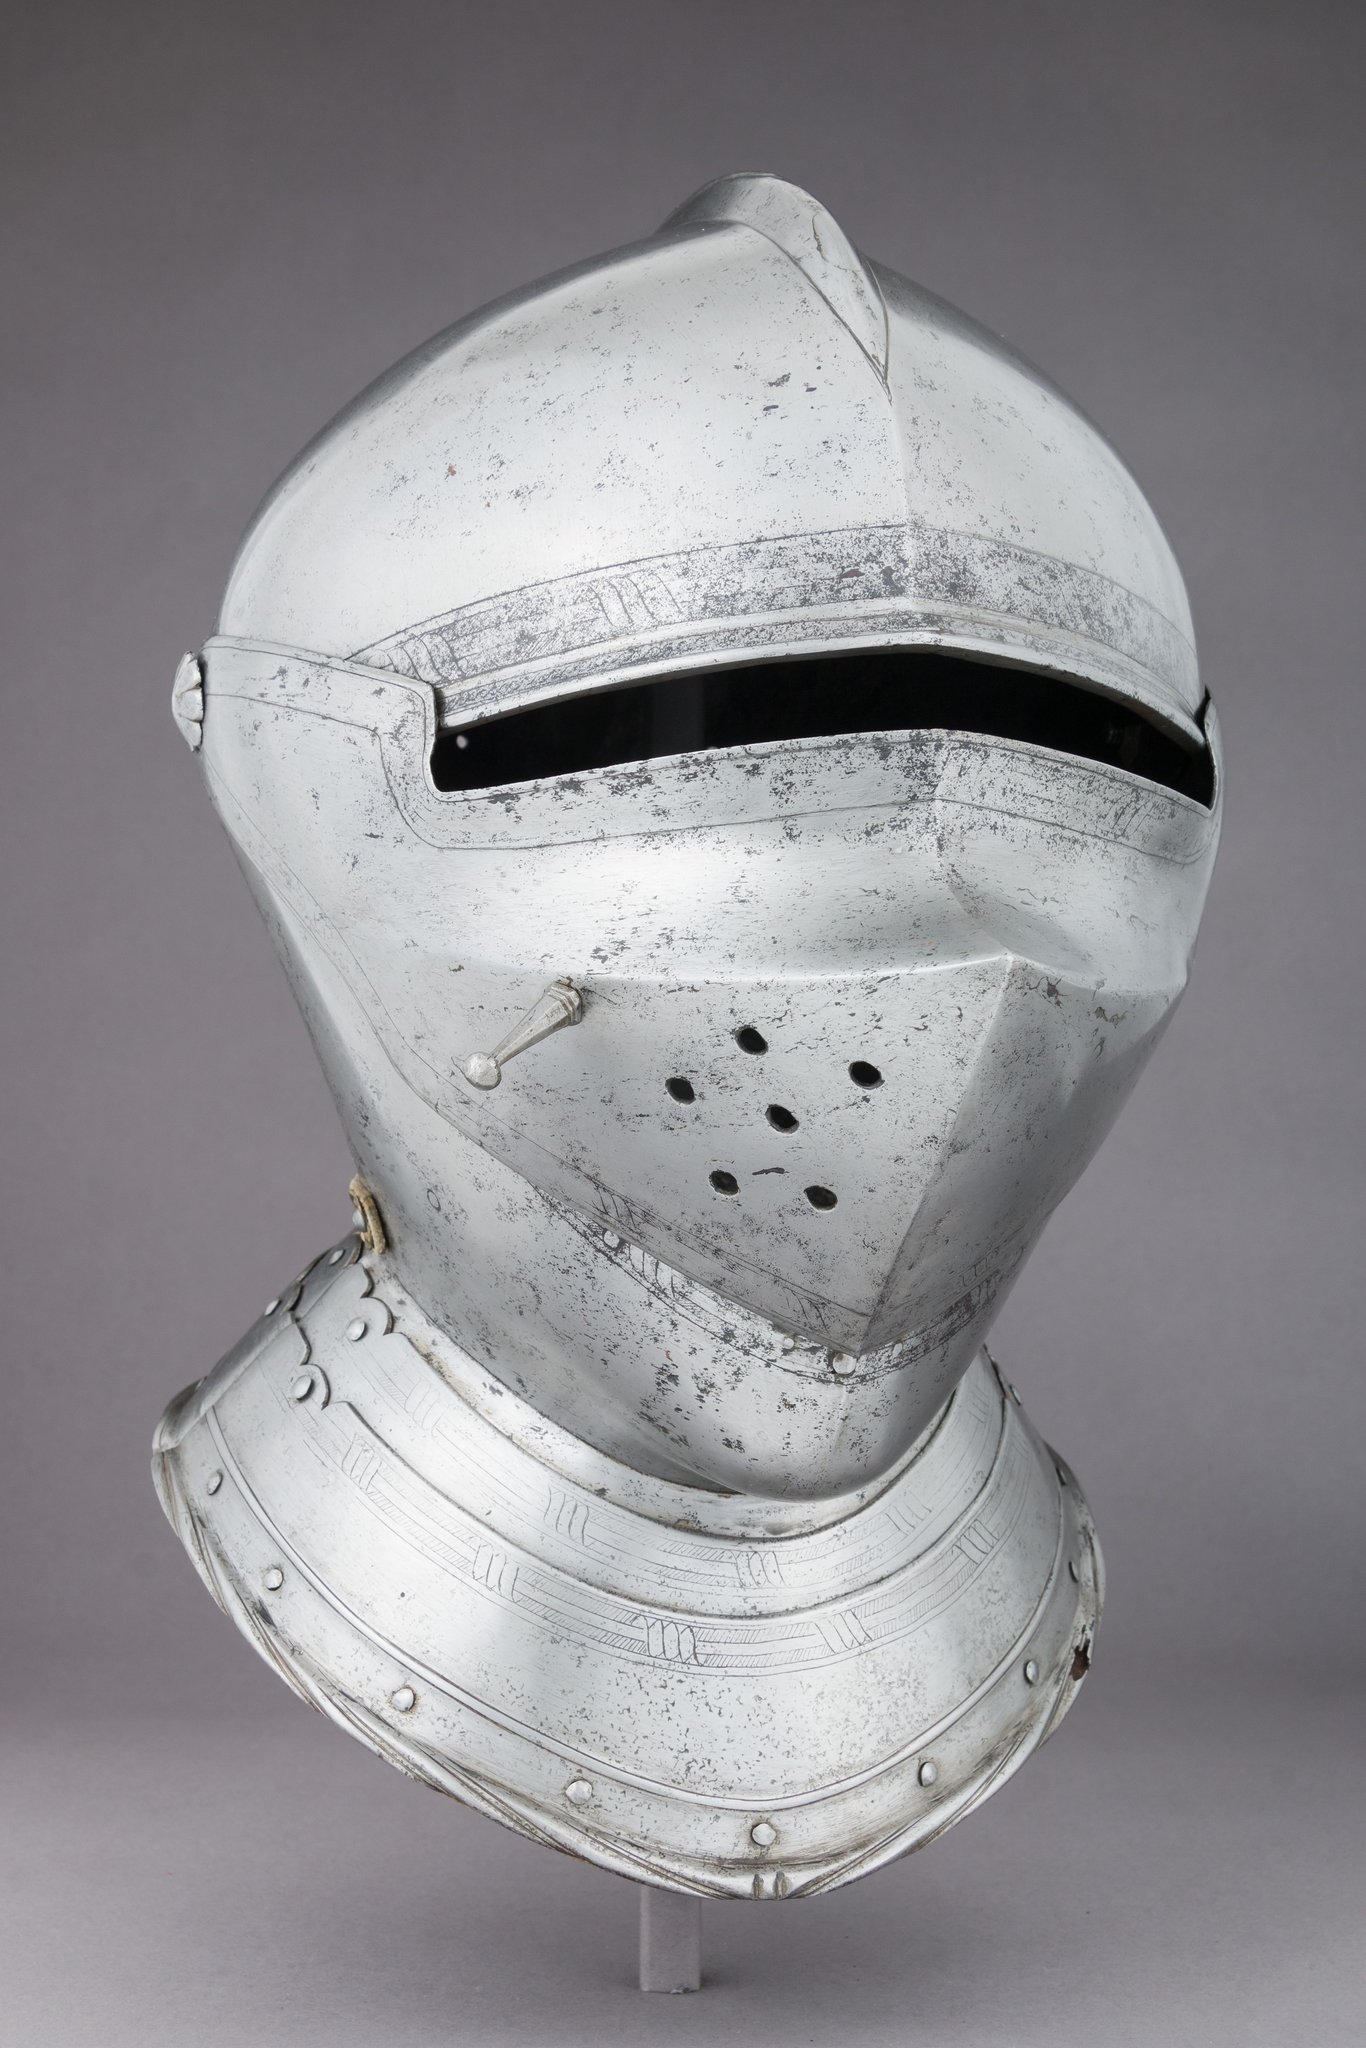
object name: close helmet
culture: flemish or italian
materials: copper alloy, leather, steel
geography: italy